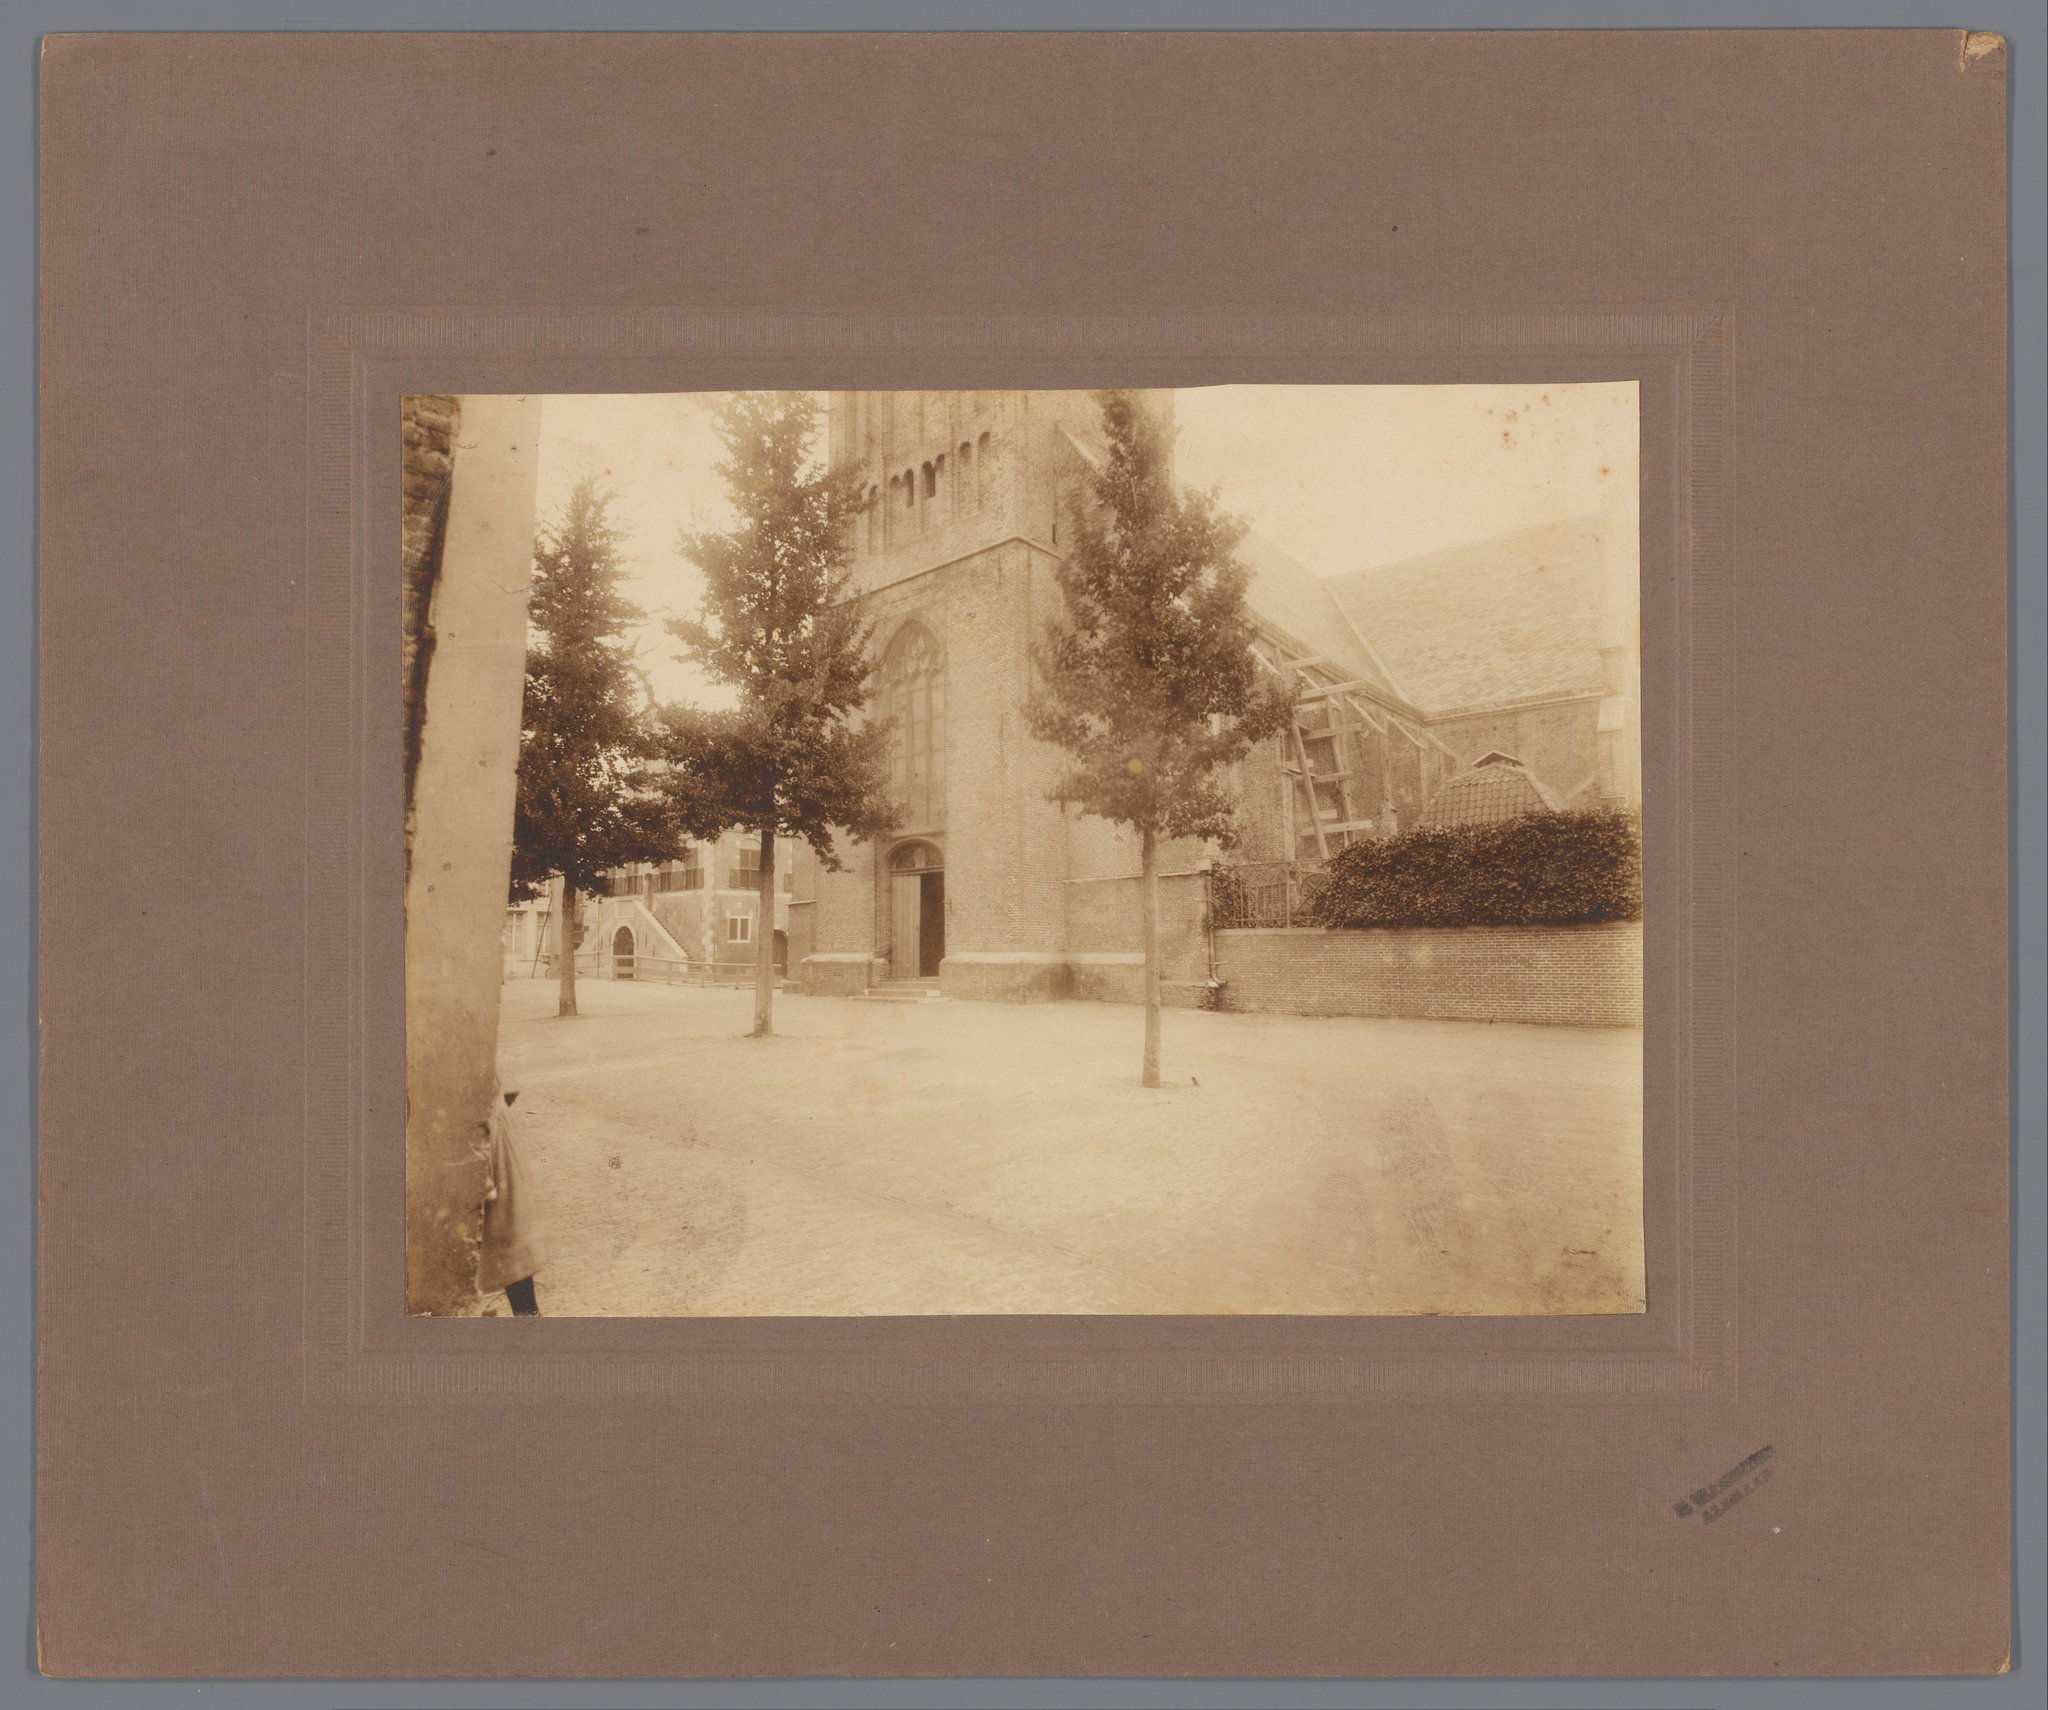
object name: photograph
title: Aanzicht op ingang en een deel van de toren van de Nederlands Hervormde Kerk in De Rijp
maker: leonard vlaanderen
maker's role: fotograaf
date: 1921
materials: cardboard, photographic support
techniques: gelatin silver print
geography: alkmaar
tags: de rijp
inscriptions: stamp: ‘L.Vlaanderen//Alkmaar’, annotation: ‘De Rijp 1921’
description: Aanzicht op de Nederlands Hervormde Kerk in De Rijp, ingangsportaal, open deur, bomen ervoor, rechts zijn houten stellingen te zien (werkzaamheden?), links een aparte afsnijding: een muur met daarachter een kind geleund, waarvan alleen het lichaam zichtbaar is.